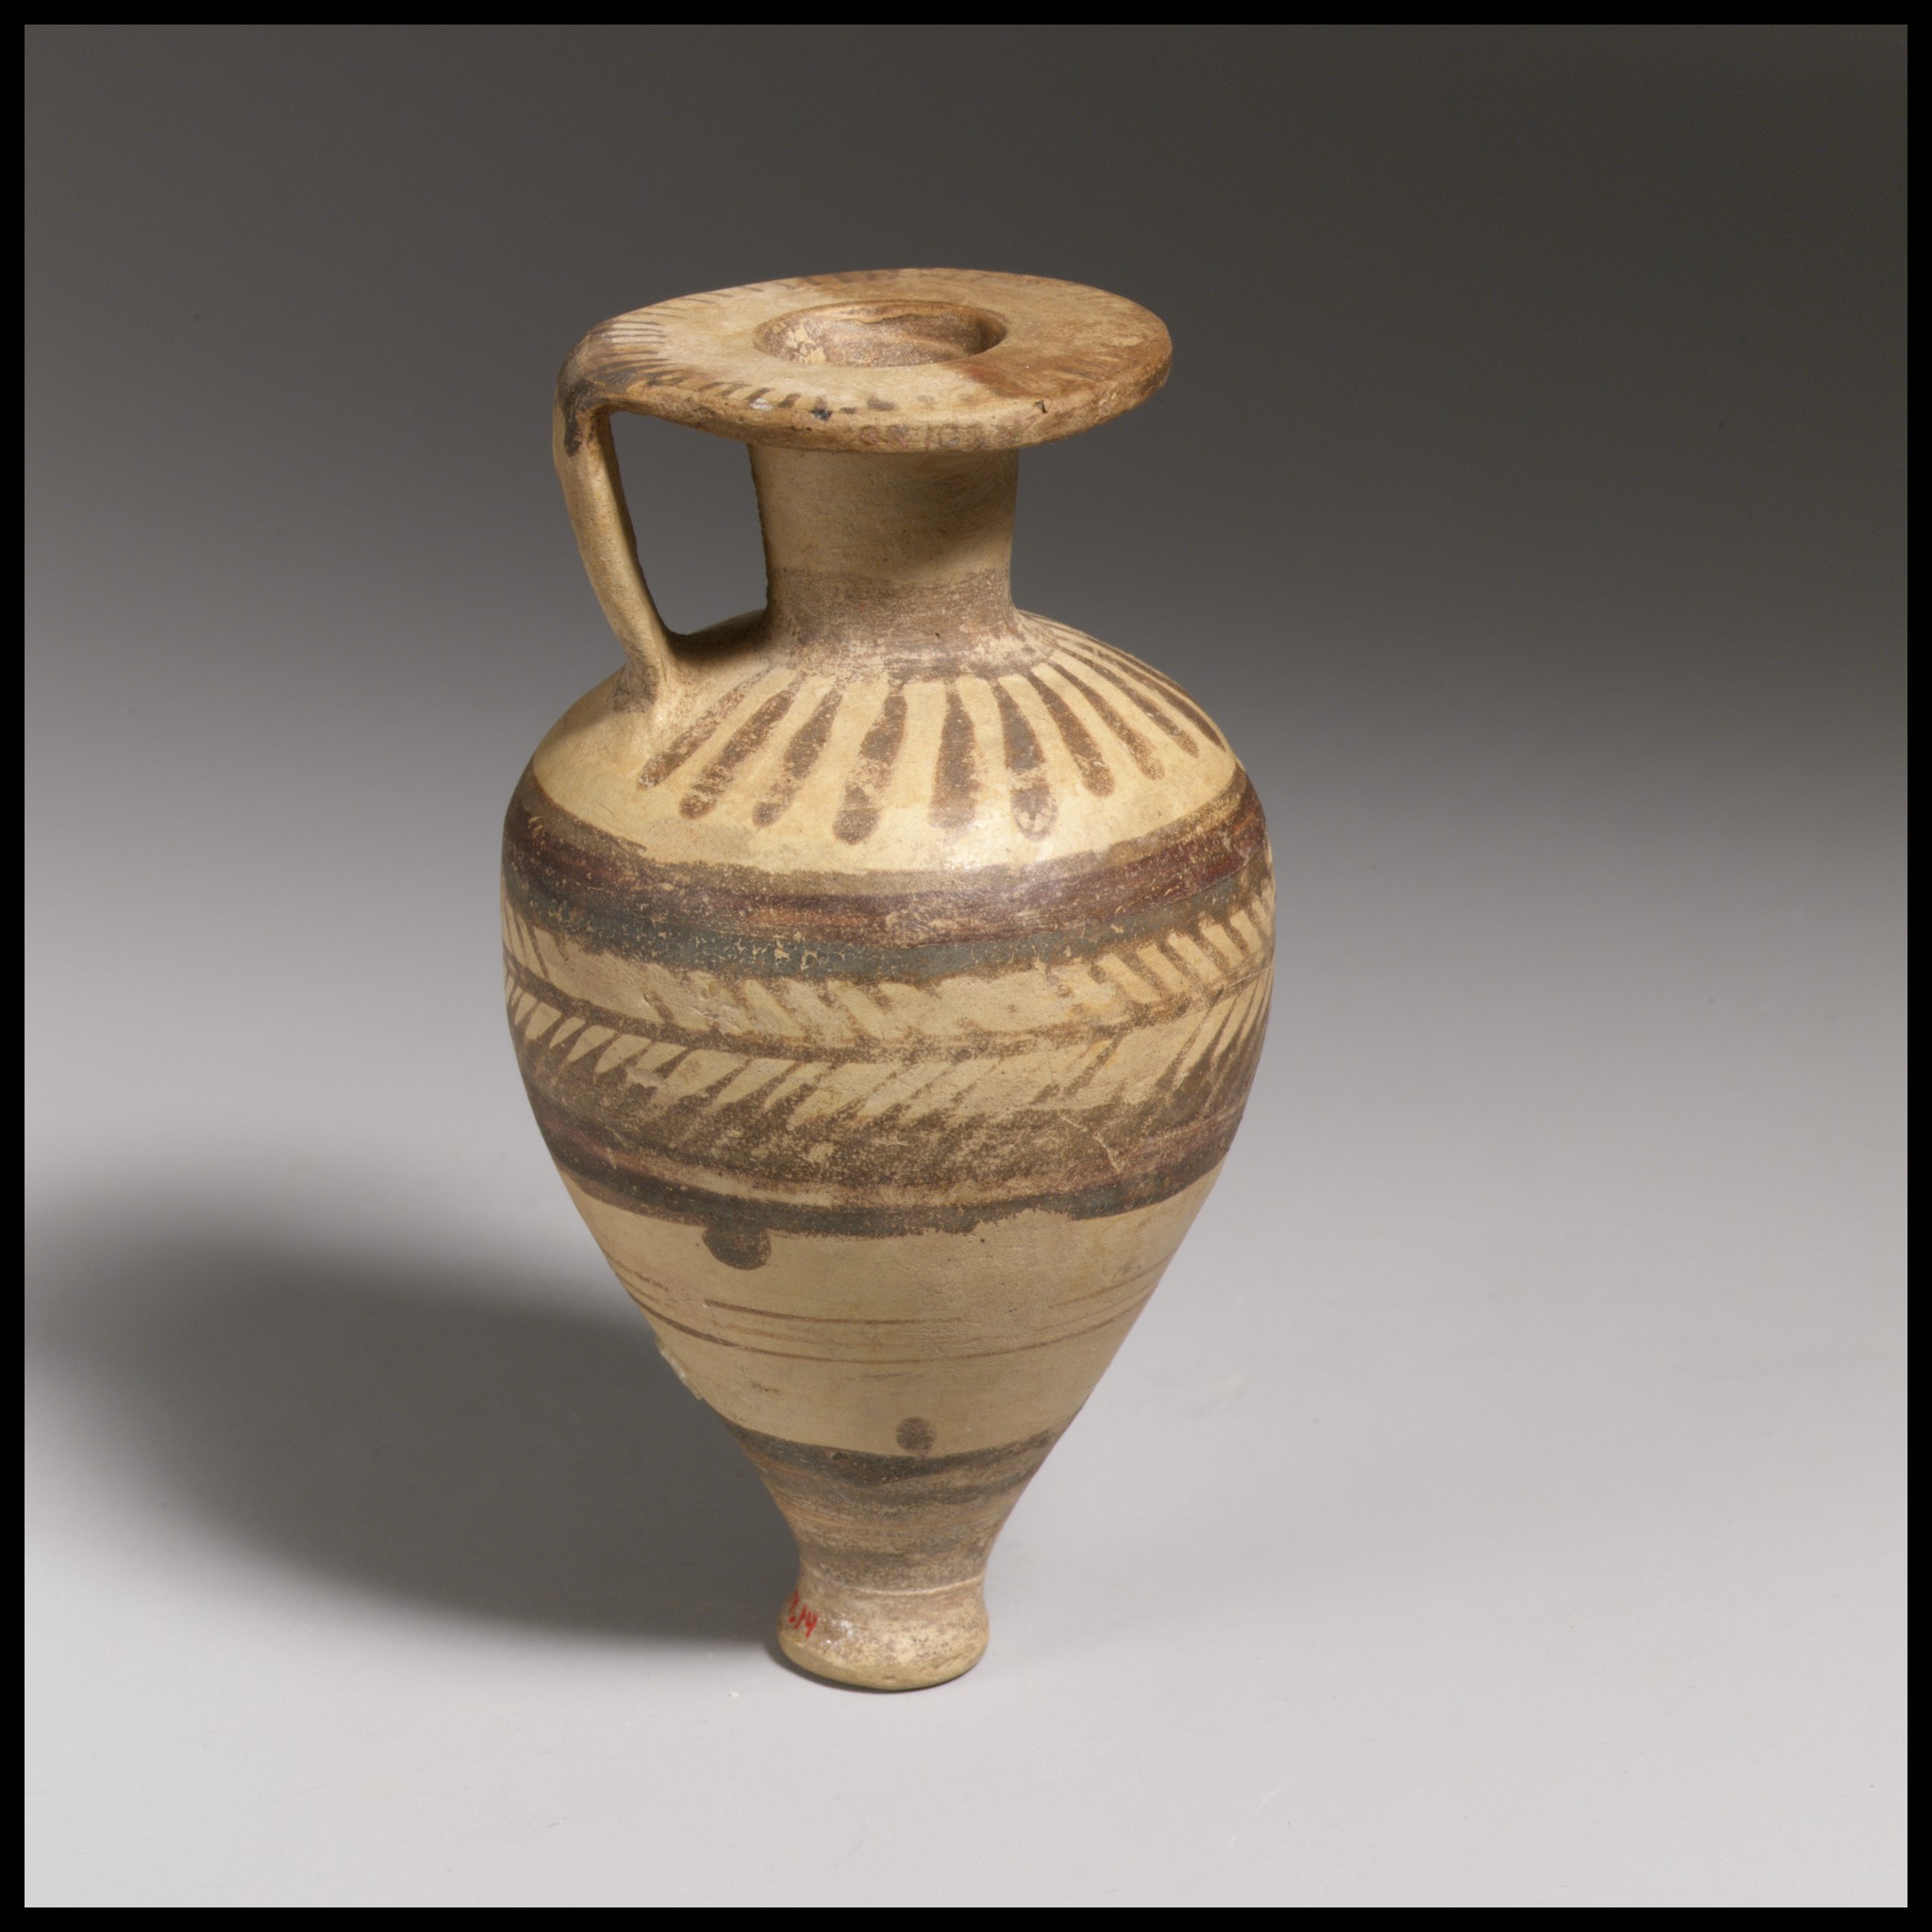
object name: lekythos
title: Terracotta pointed aryballos (oil flask)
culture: etruscan, italo-corinthian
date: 634-568 BCE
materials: terracotta